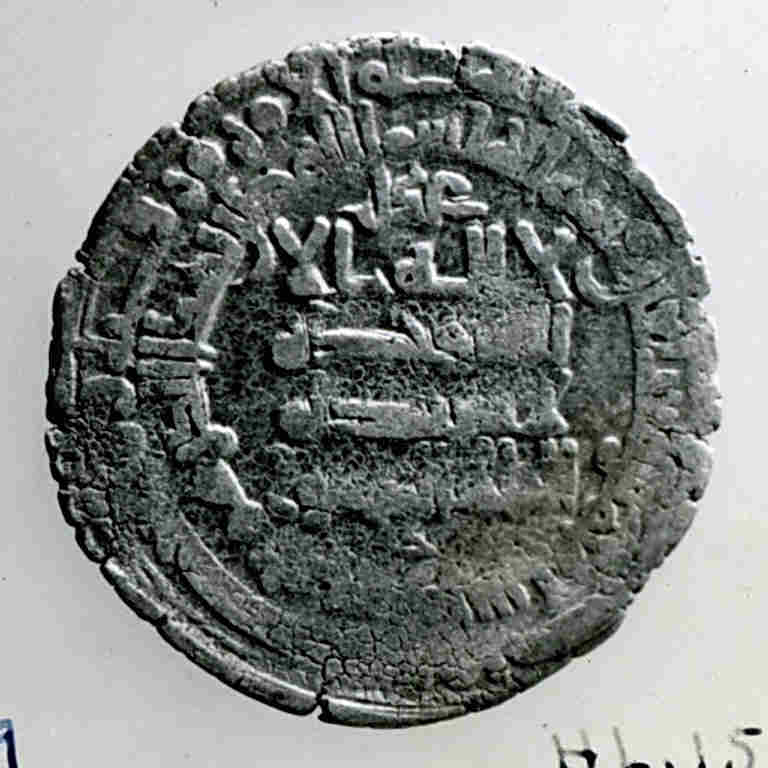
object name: coin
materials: silver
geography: iran